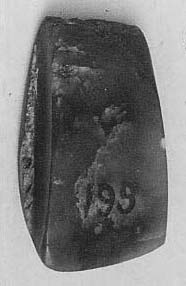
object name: knife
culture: swiss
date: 1902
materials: jade